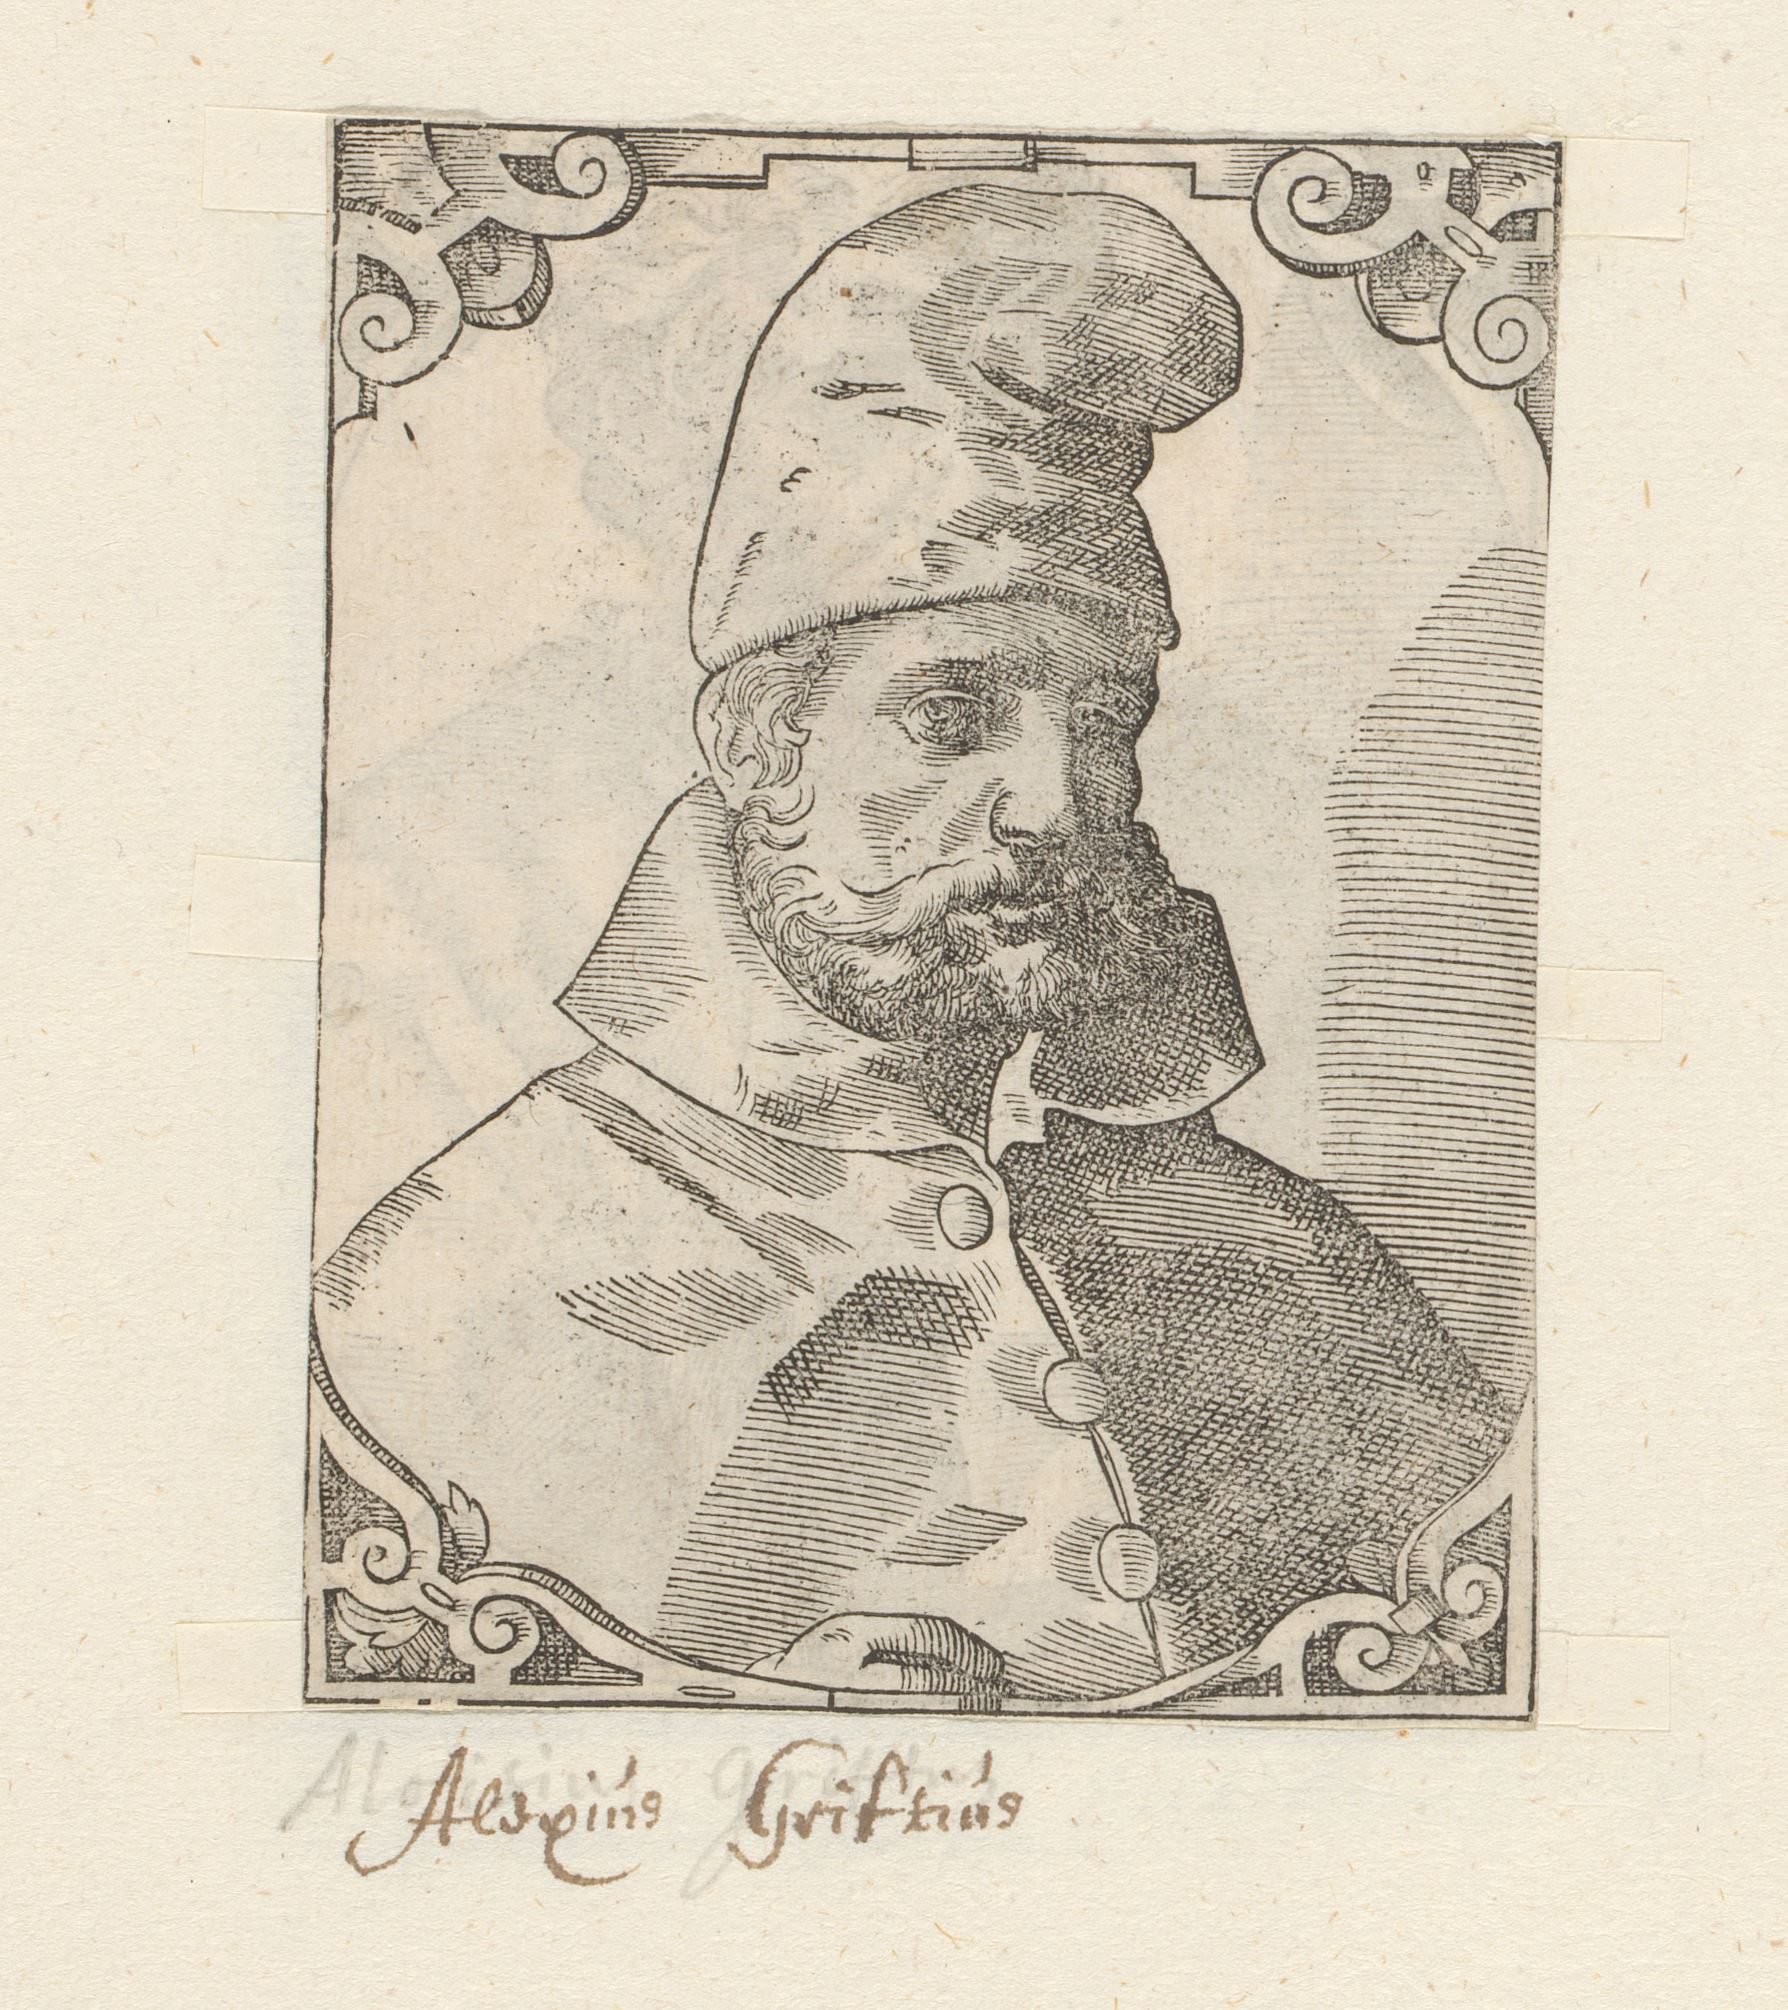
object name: album leaf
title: Portret van Lodovico Gritti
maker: Anonymous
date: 1549-1575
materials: paper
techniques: woodcut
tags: historical persons, merchant, salesman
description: Prent gebruikt in: Giovio, Paolo. Elogia Virorum bellica virtute illustrium (...). Bazel: Peter Perna, 1575.